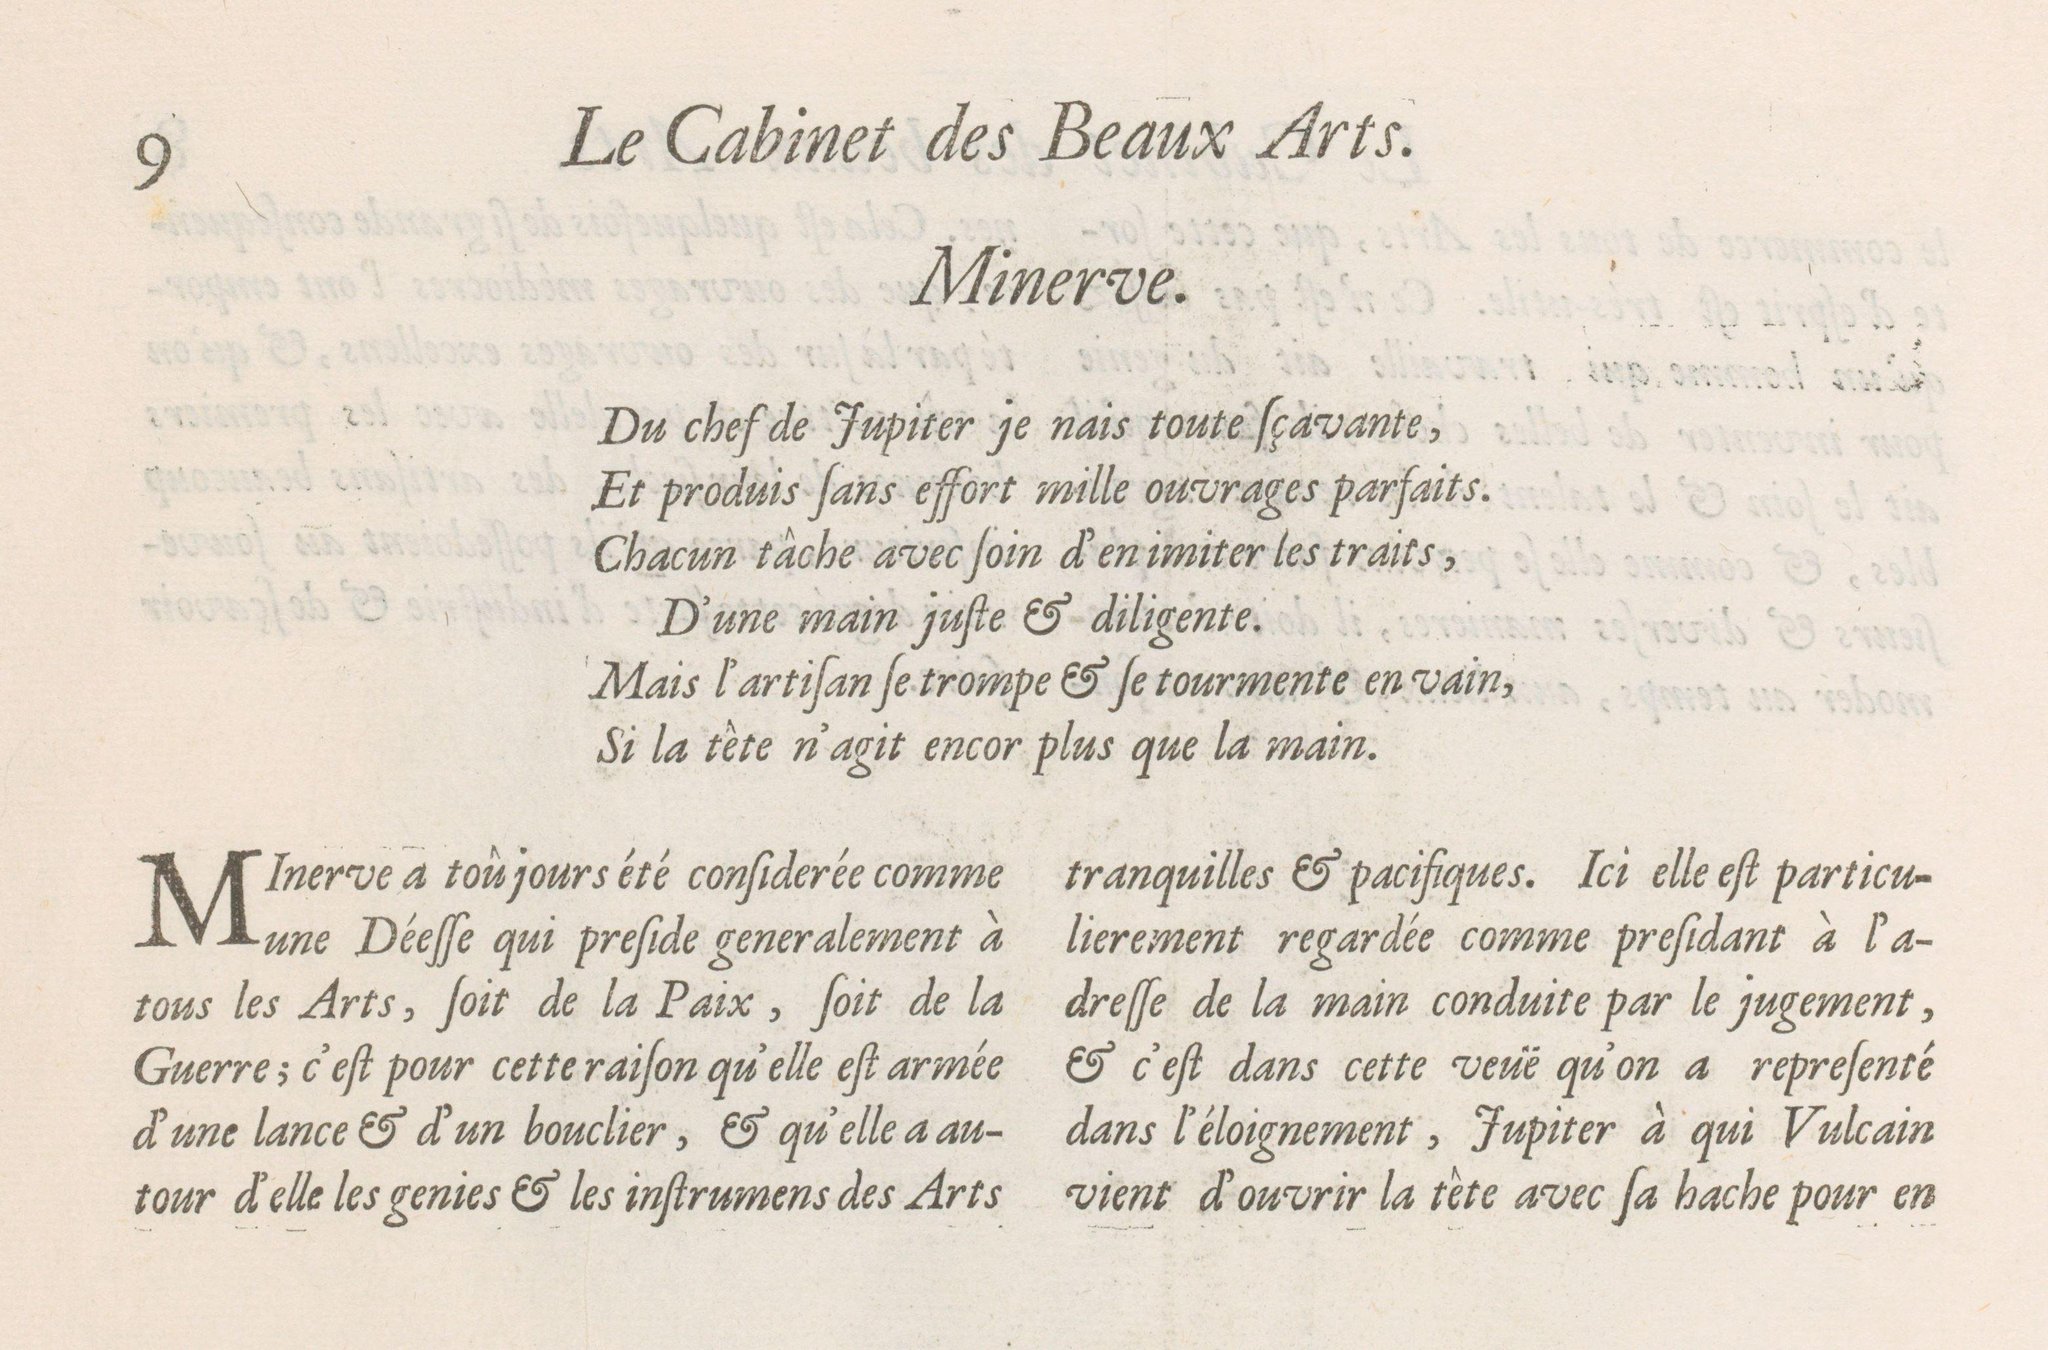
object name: text sheet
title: Minerve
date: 1695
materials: paper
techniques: letterpress printing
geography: paris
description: Verklaring van de prent met voorstelling van Minerva in het Frans. Pagina 9. Tekstblad maakt deel uit van een album.